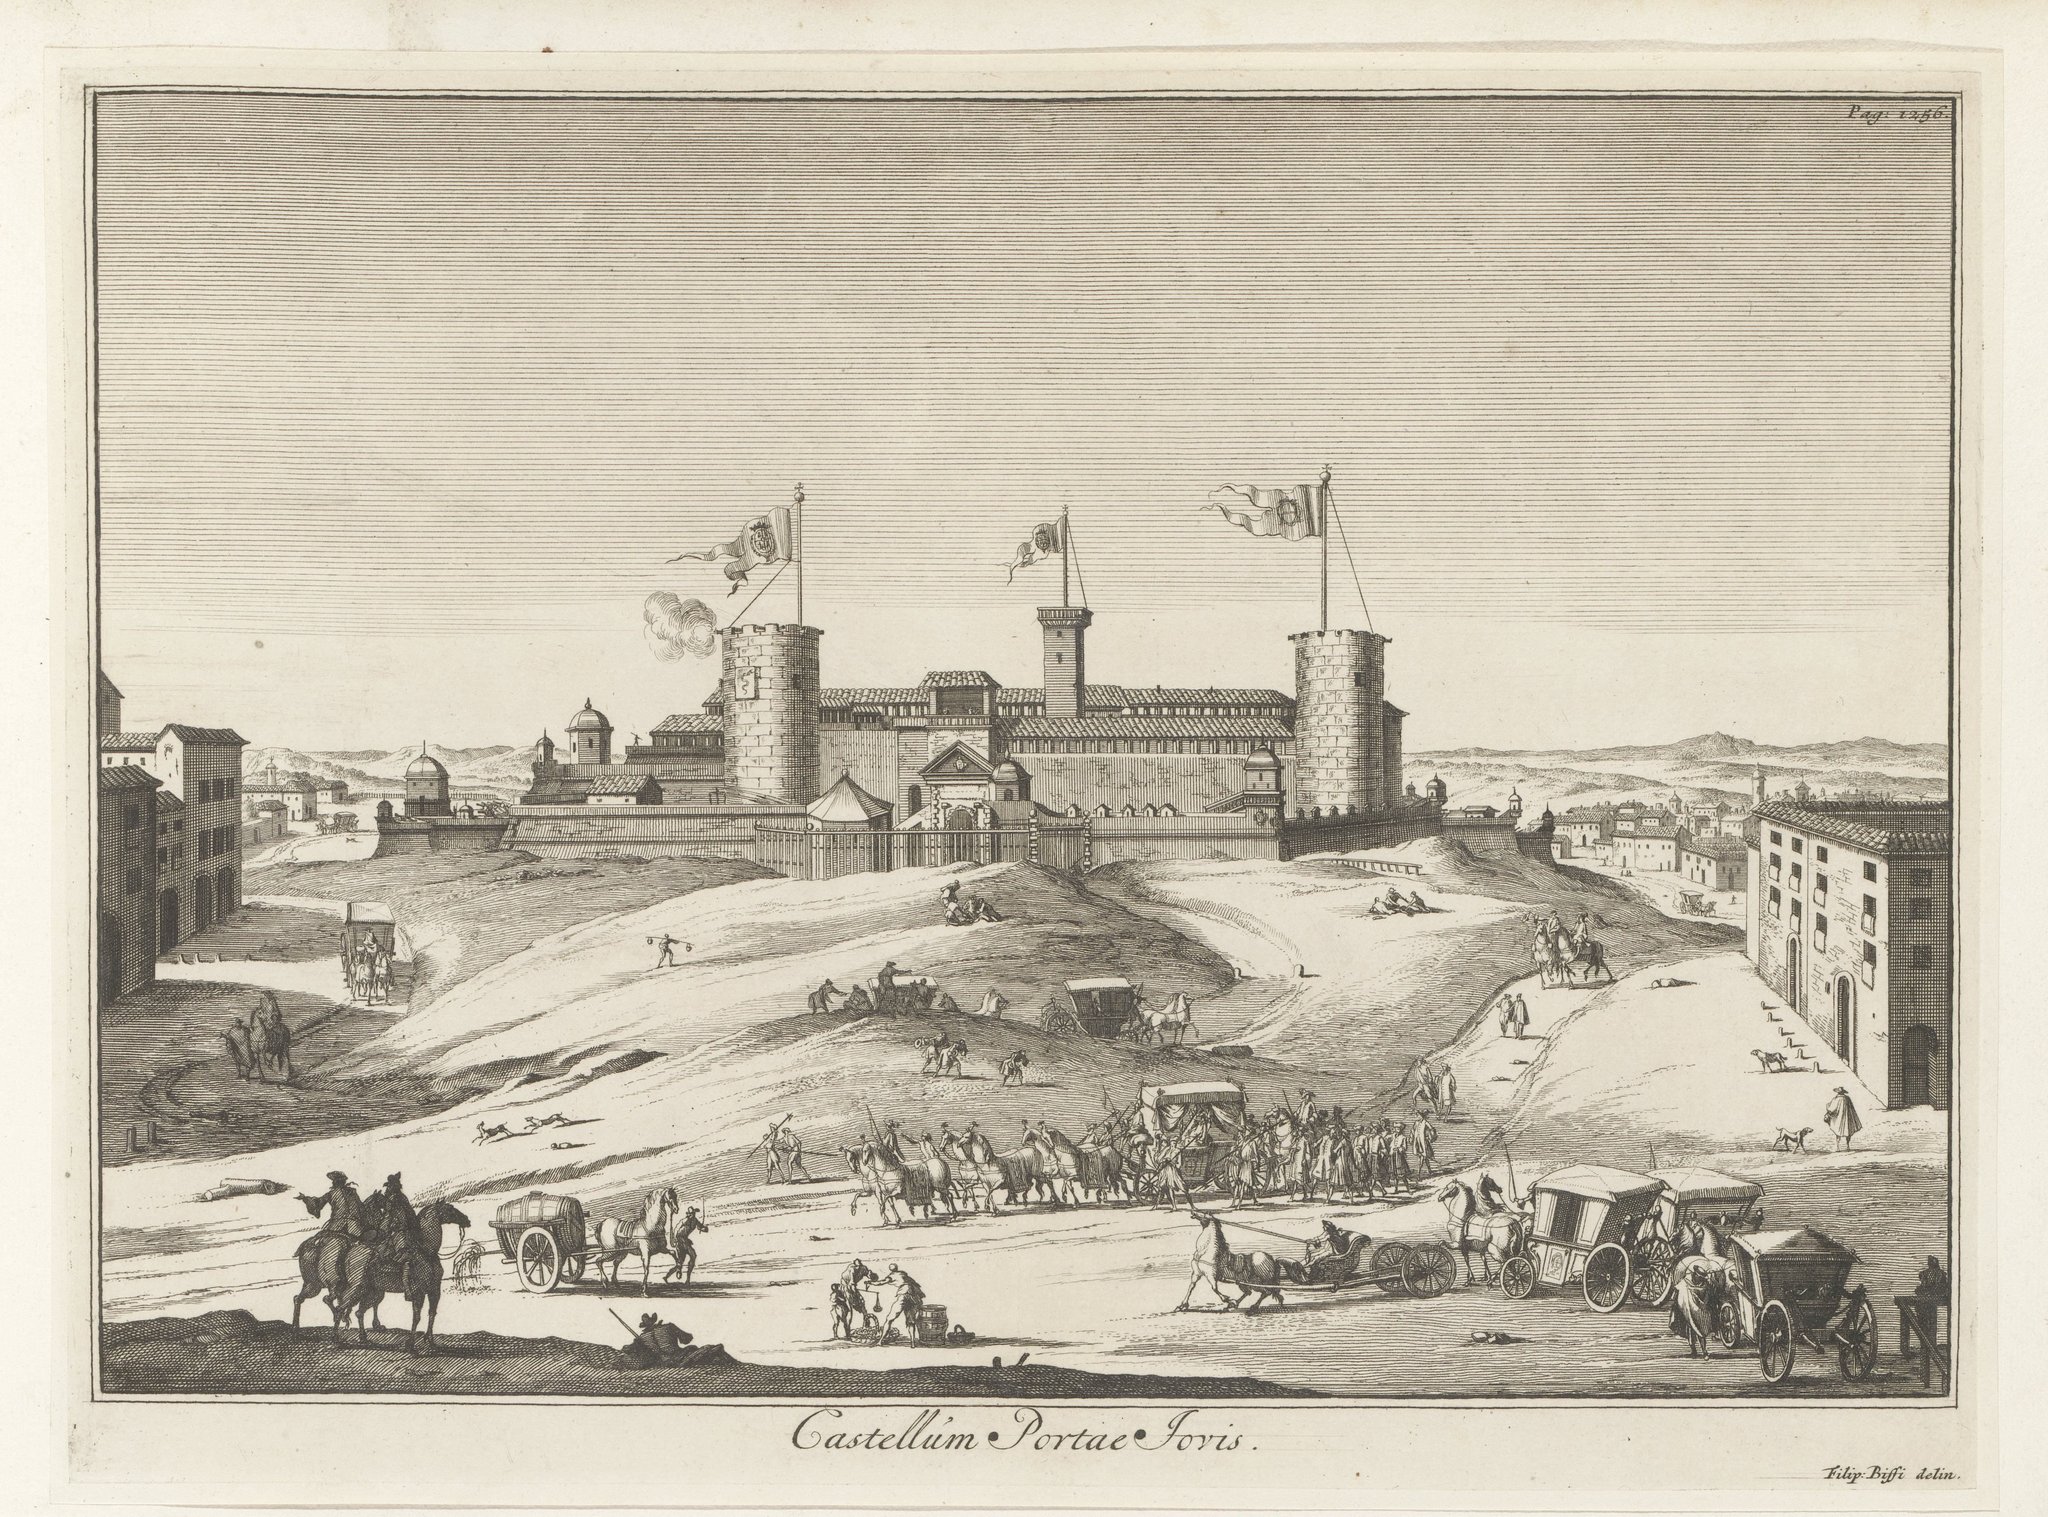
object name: book illustration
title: Kasteel in Italië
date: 1704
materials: paper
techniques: etching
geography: italy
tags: city-view, and landscape with man-made constructions, castle, italy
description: Prent uit: Giovanni Giorgio Grevio, Thesaurus Antiquitatum et Historiarum Italiae, Leiden: Pieter van der AA, 1704.